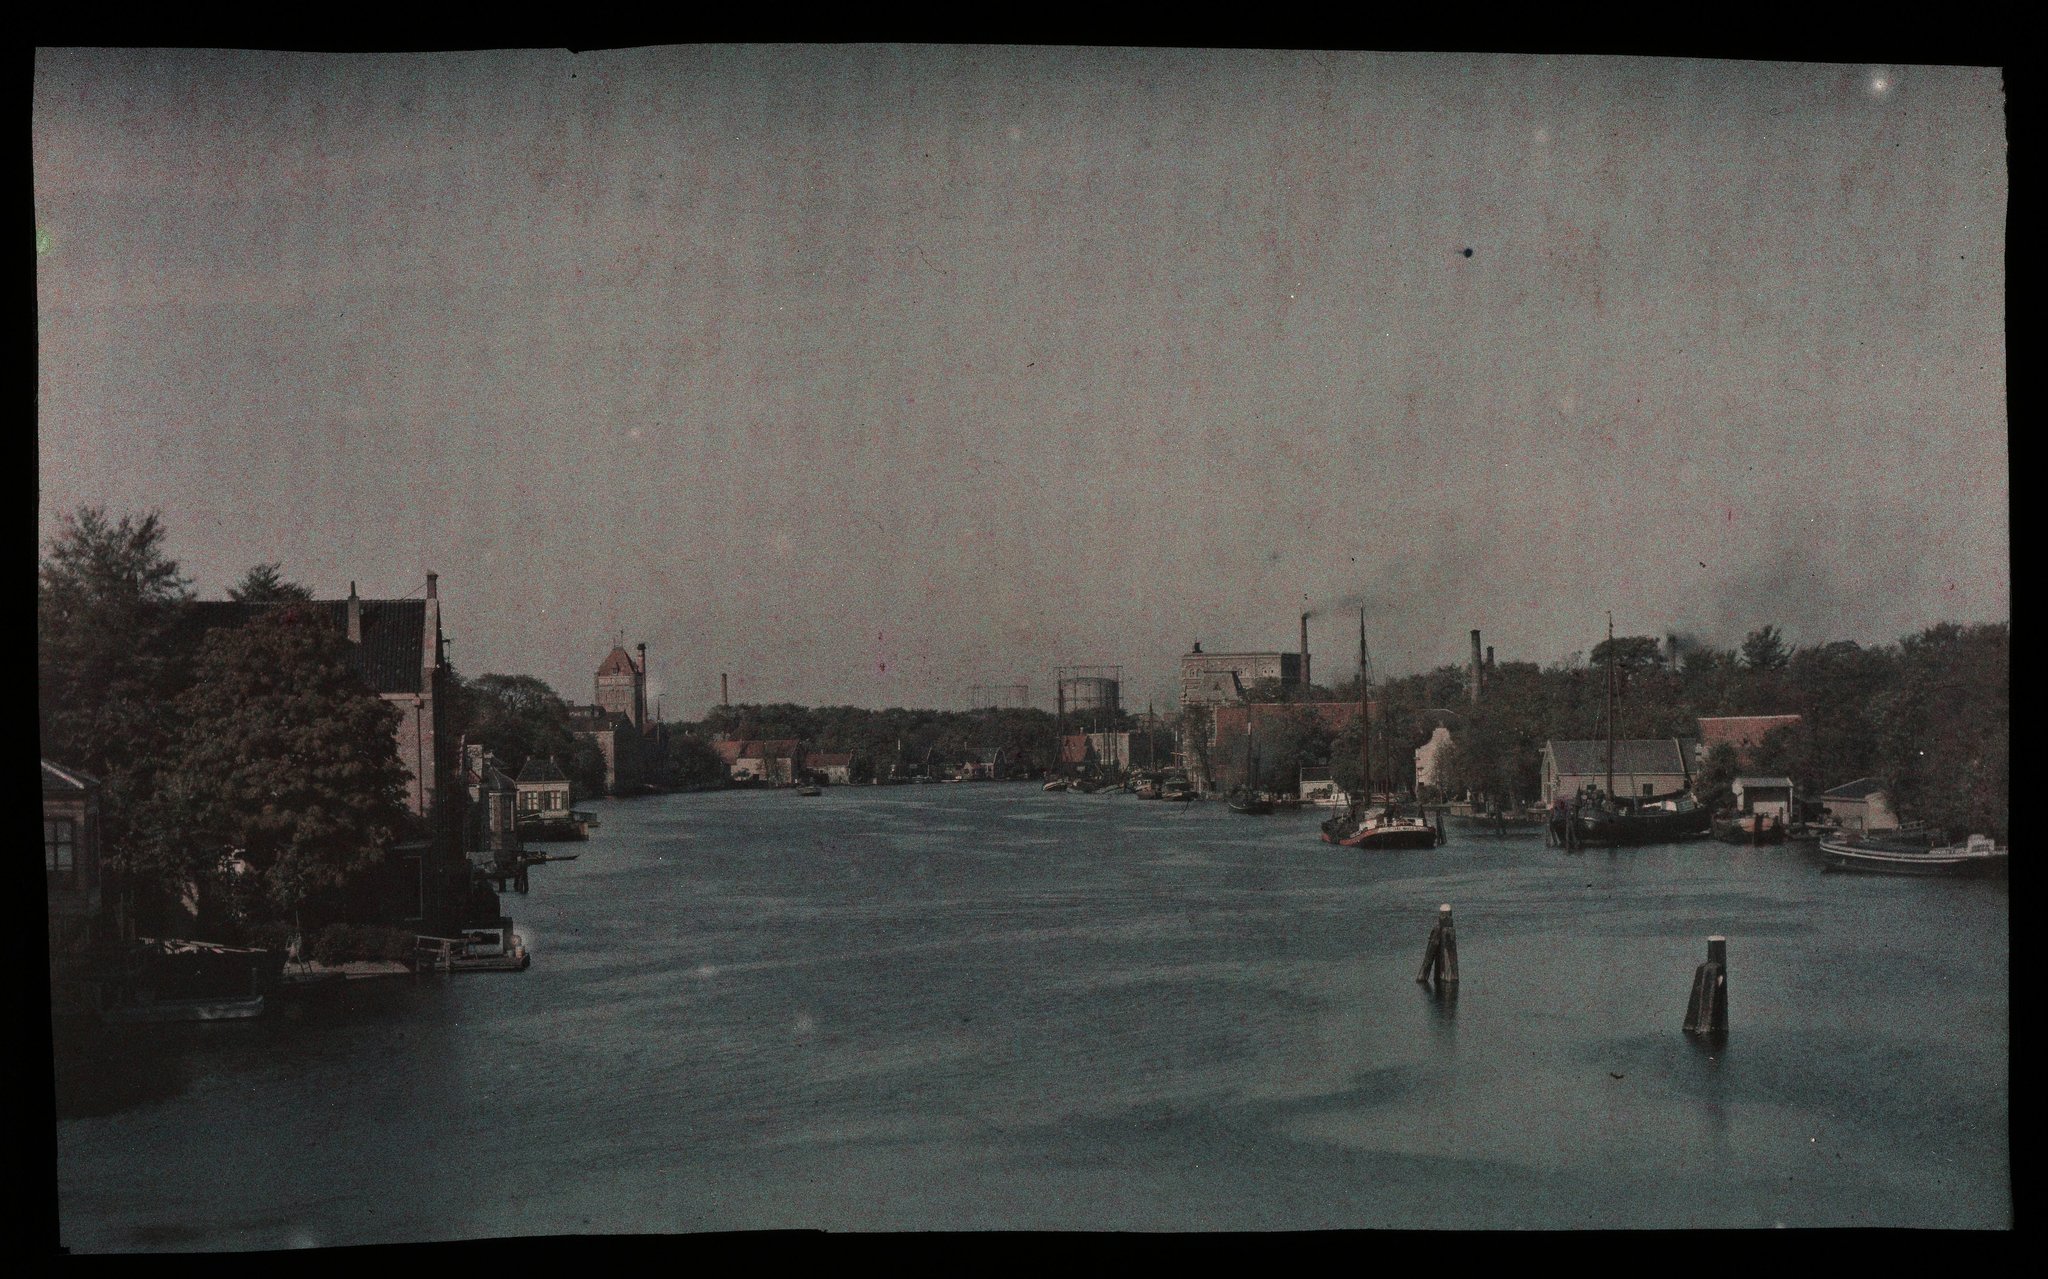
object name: color slide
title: Gezicht over de Zaan, met links de toren van de Verkade fabriek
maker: Anonymous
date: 1907-1930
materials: glass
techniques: autochrome process, slide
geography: netherlands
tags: zaan